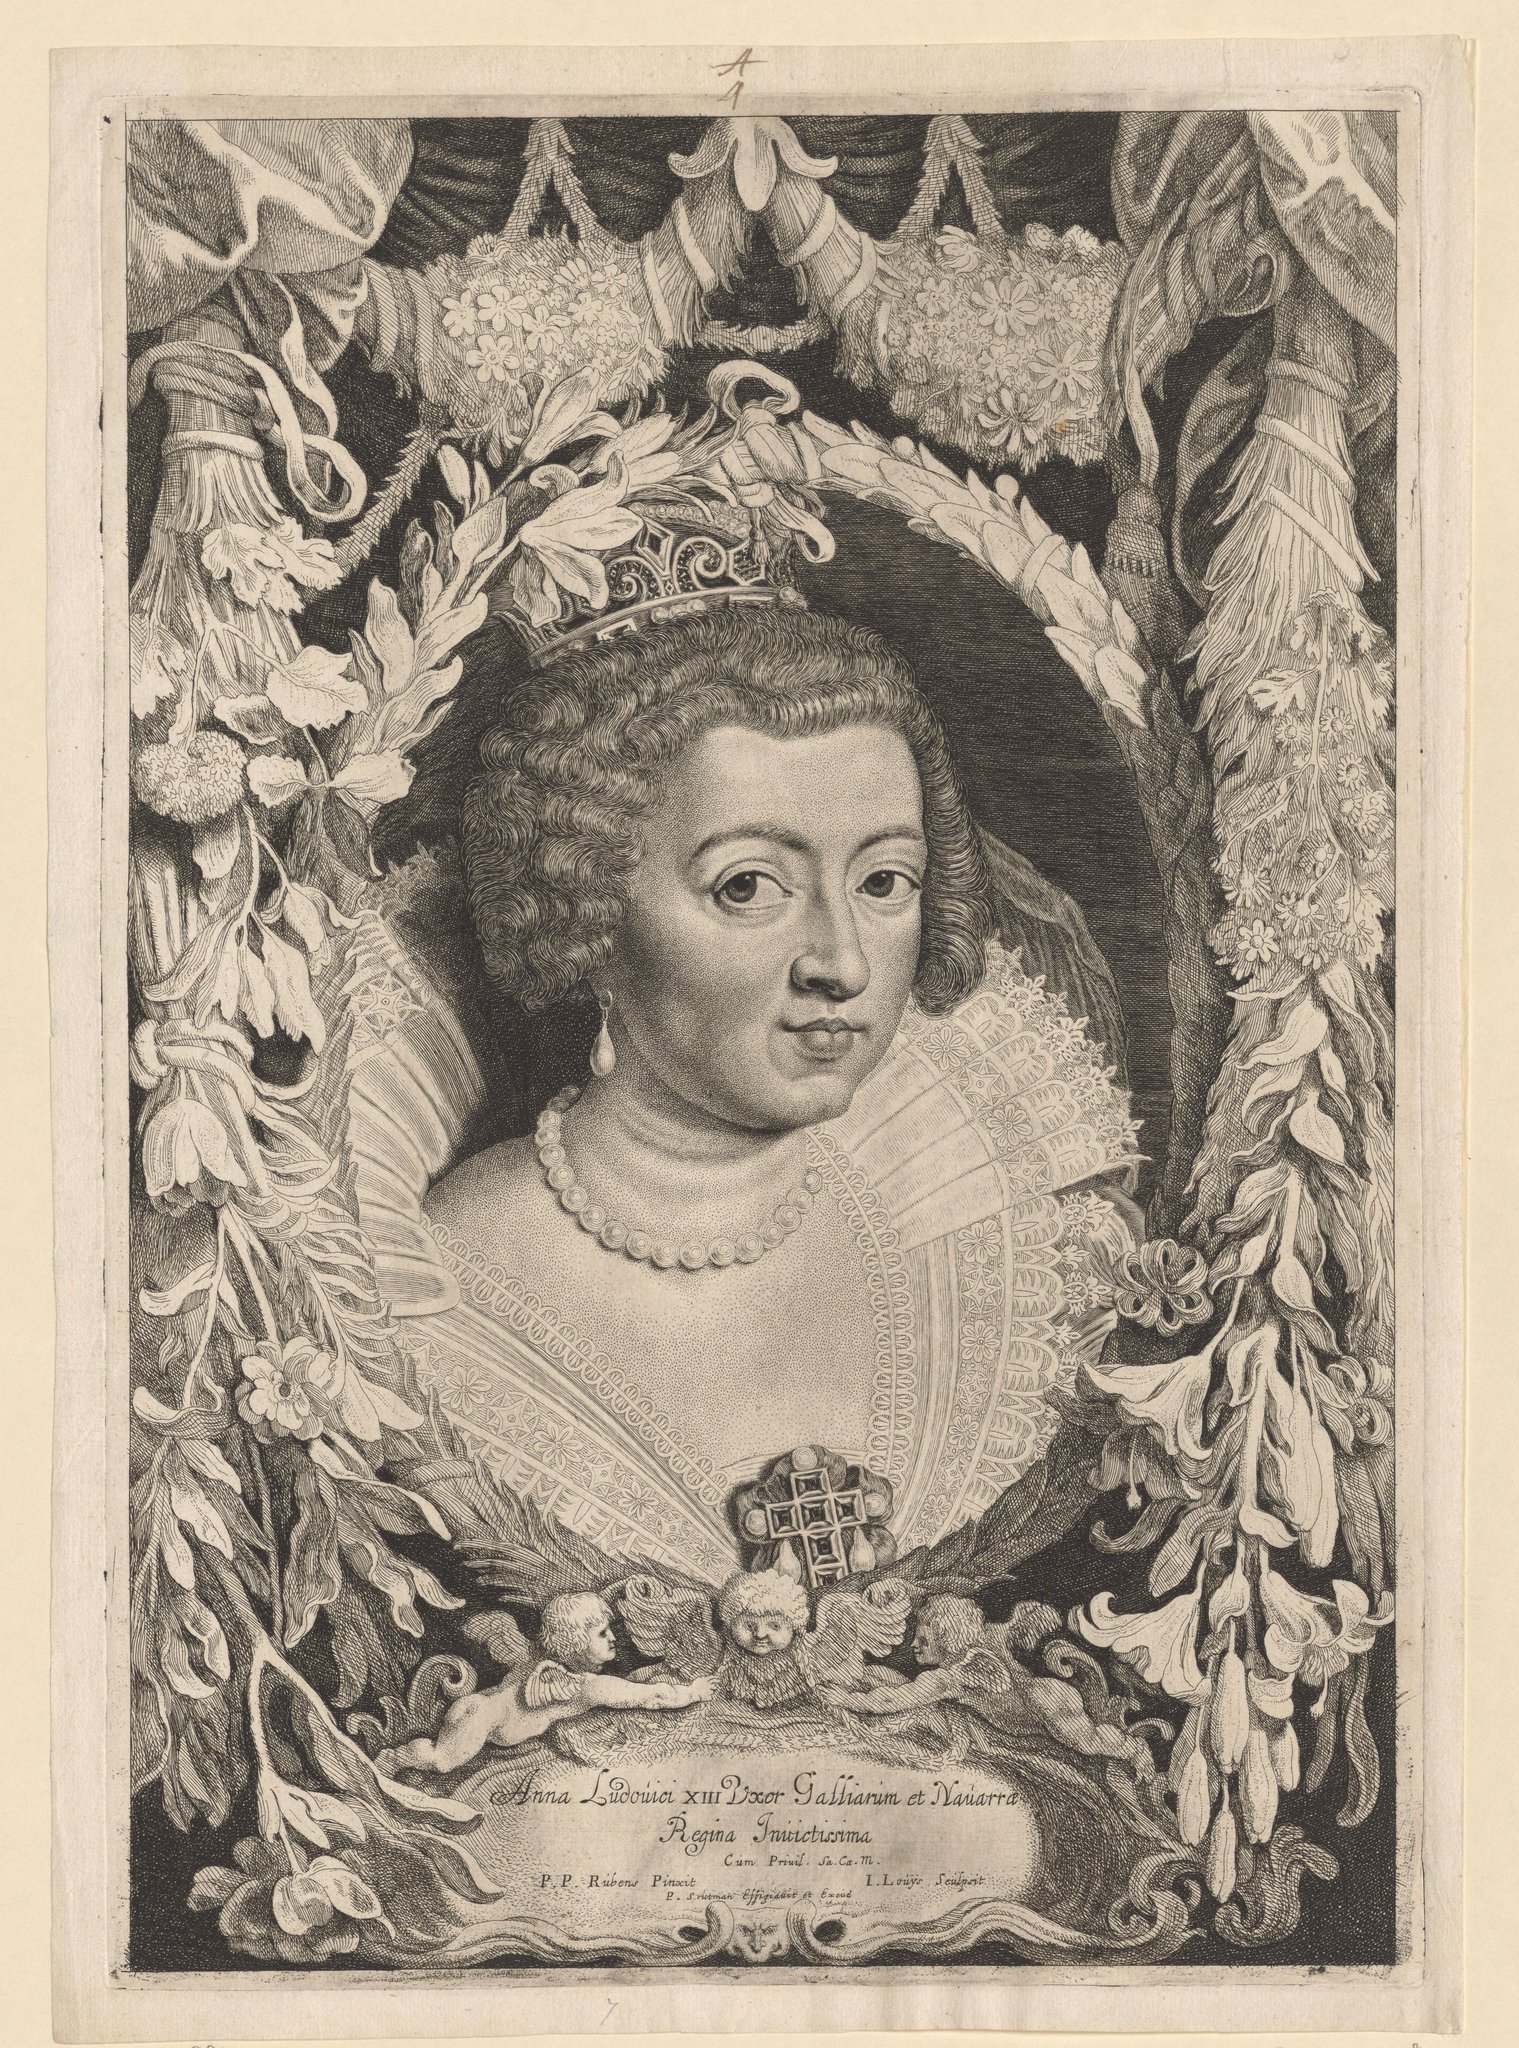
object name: print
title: Portret van Anna van Oostenrijk, koningin van Frankrijk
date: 1644-1650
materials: paper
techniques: engraving, etching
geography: haarlem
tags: anna van oostenrijk (koningin van frankrijk), historical persons - bb - woman, queen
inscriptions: collector's mark: Lugt 2228